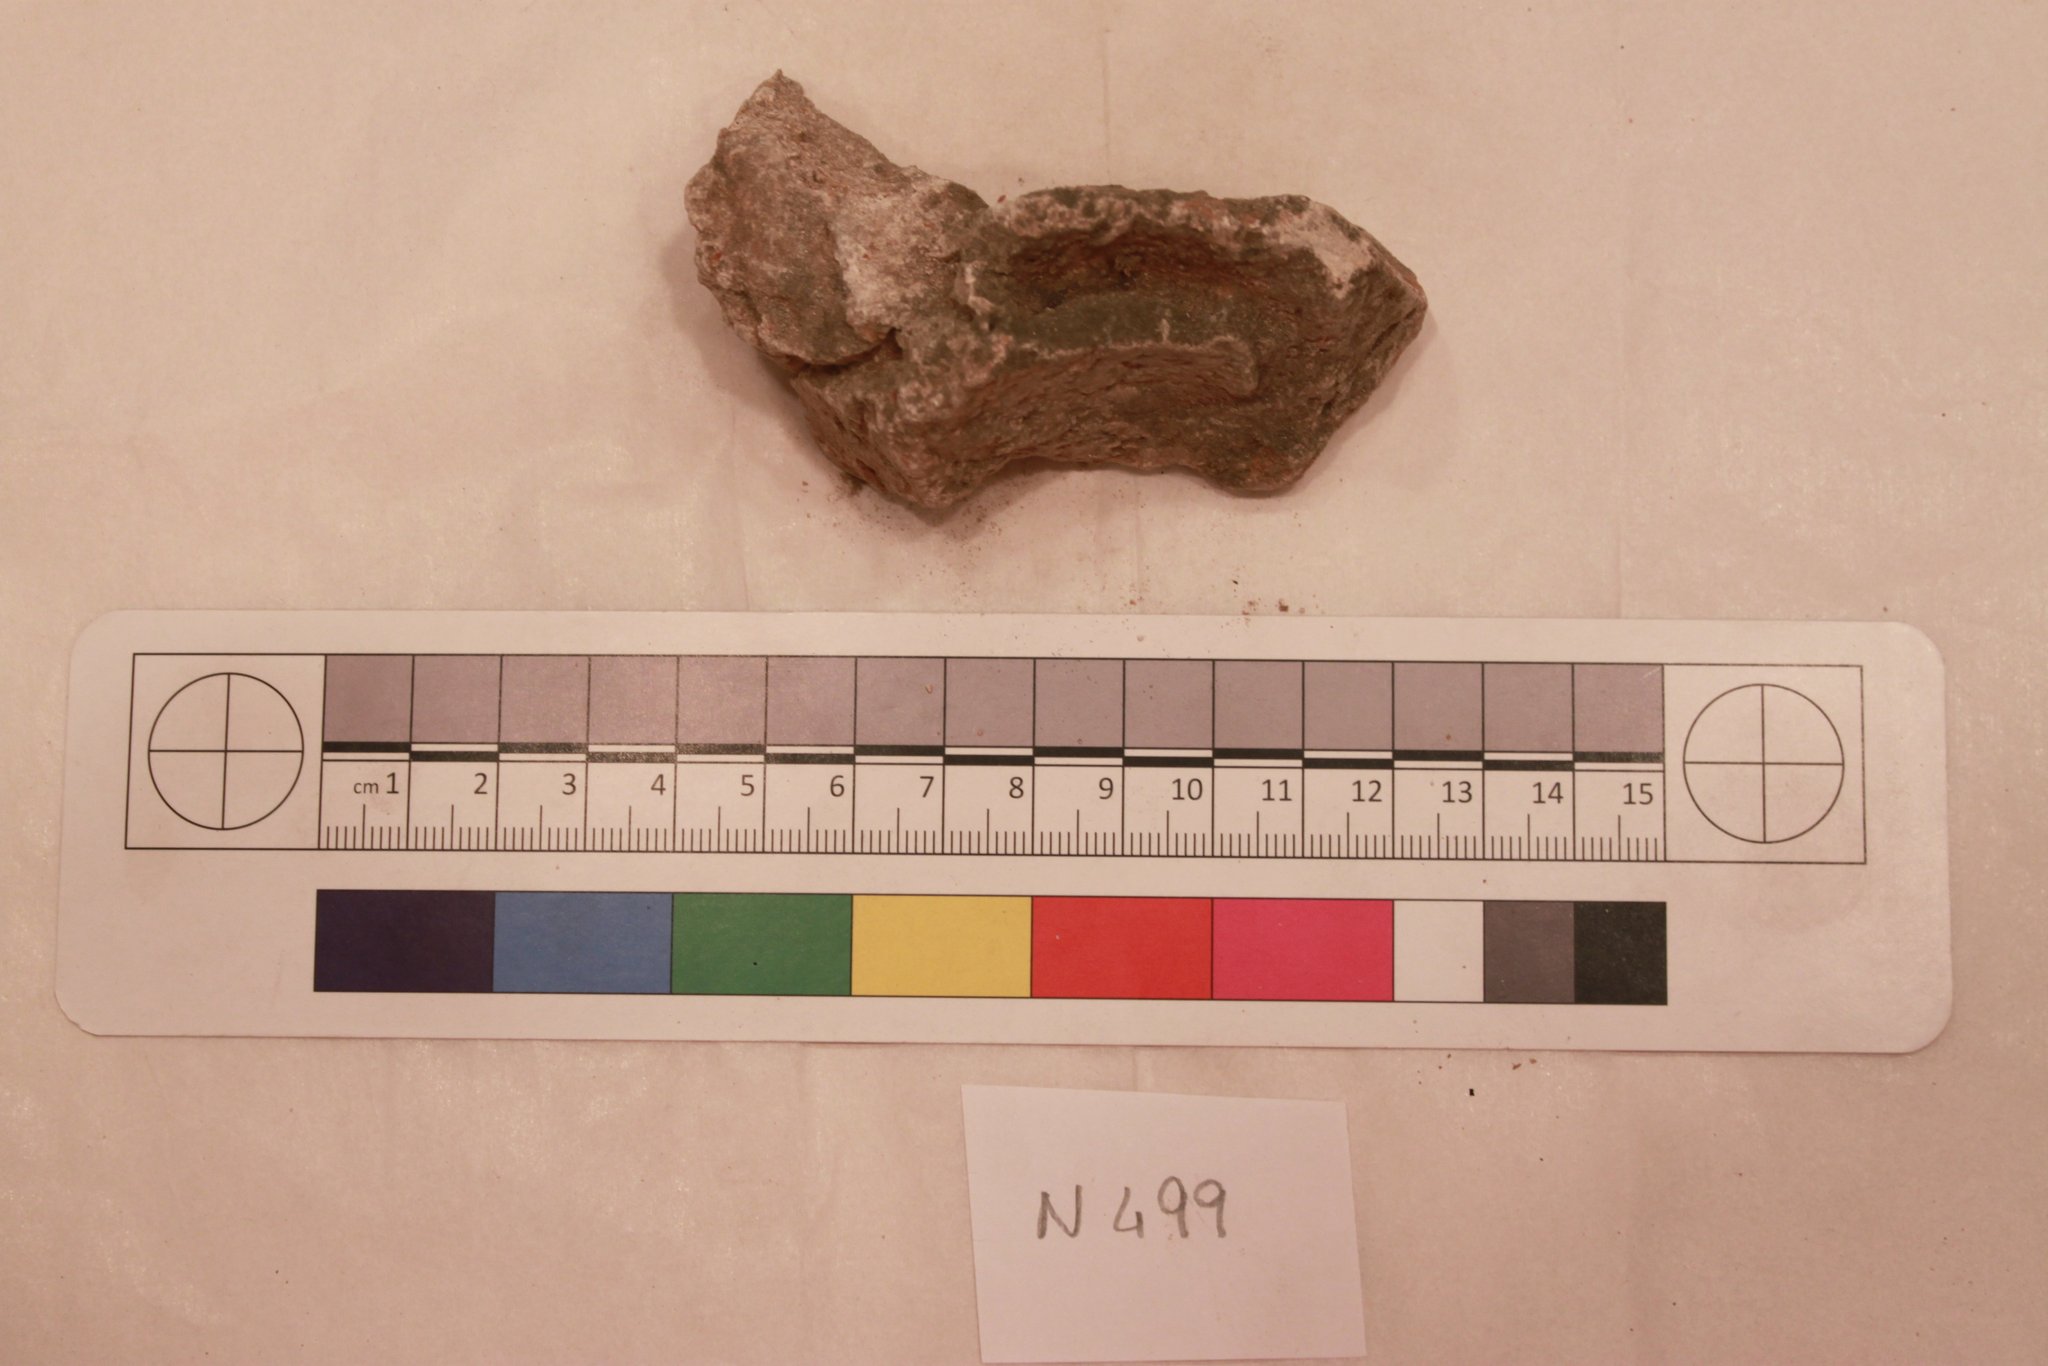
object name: fragment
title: Stucco Fragment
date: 701-1200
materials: plaster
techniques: carving, painting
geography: iran